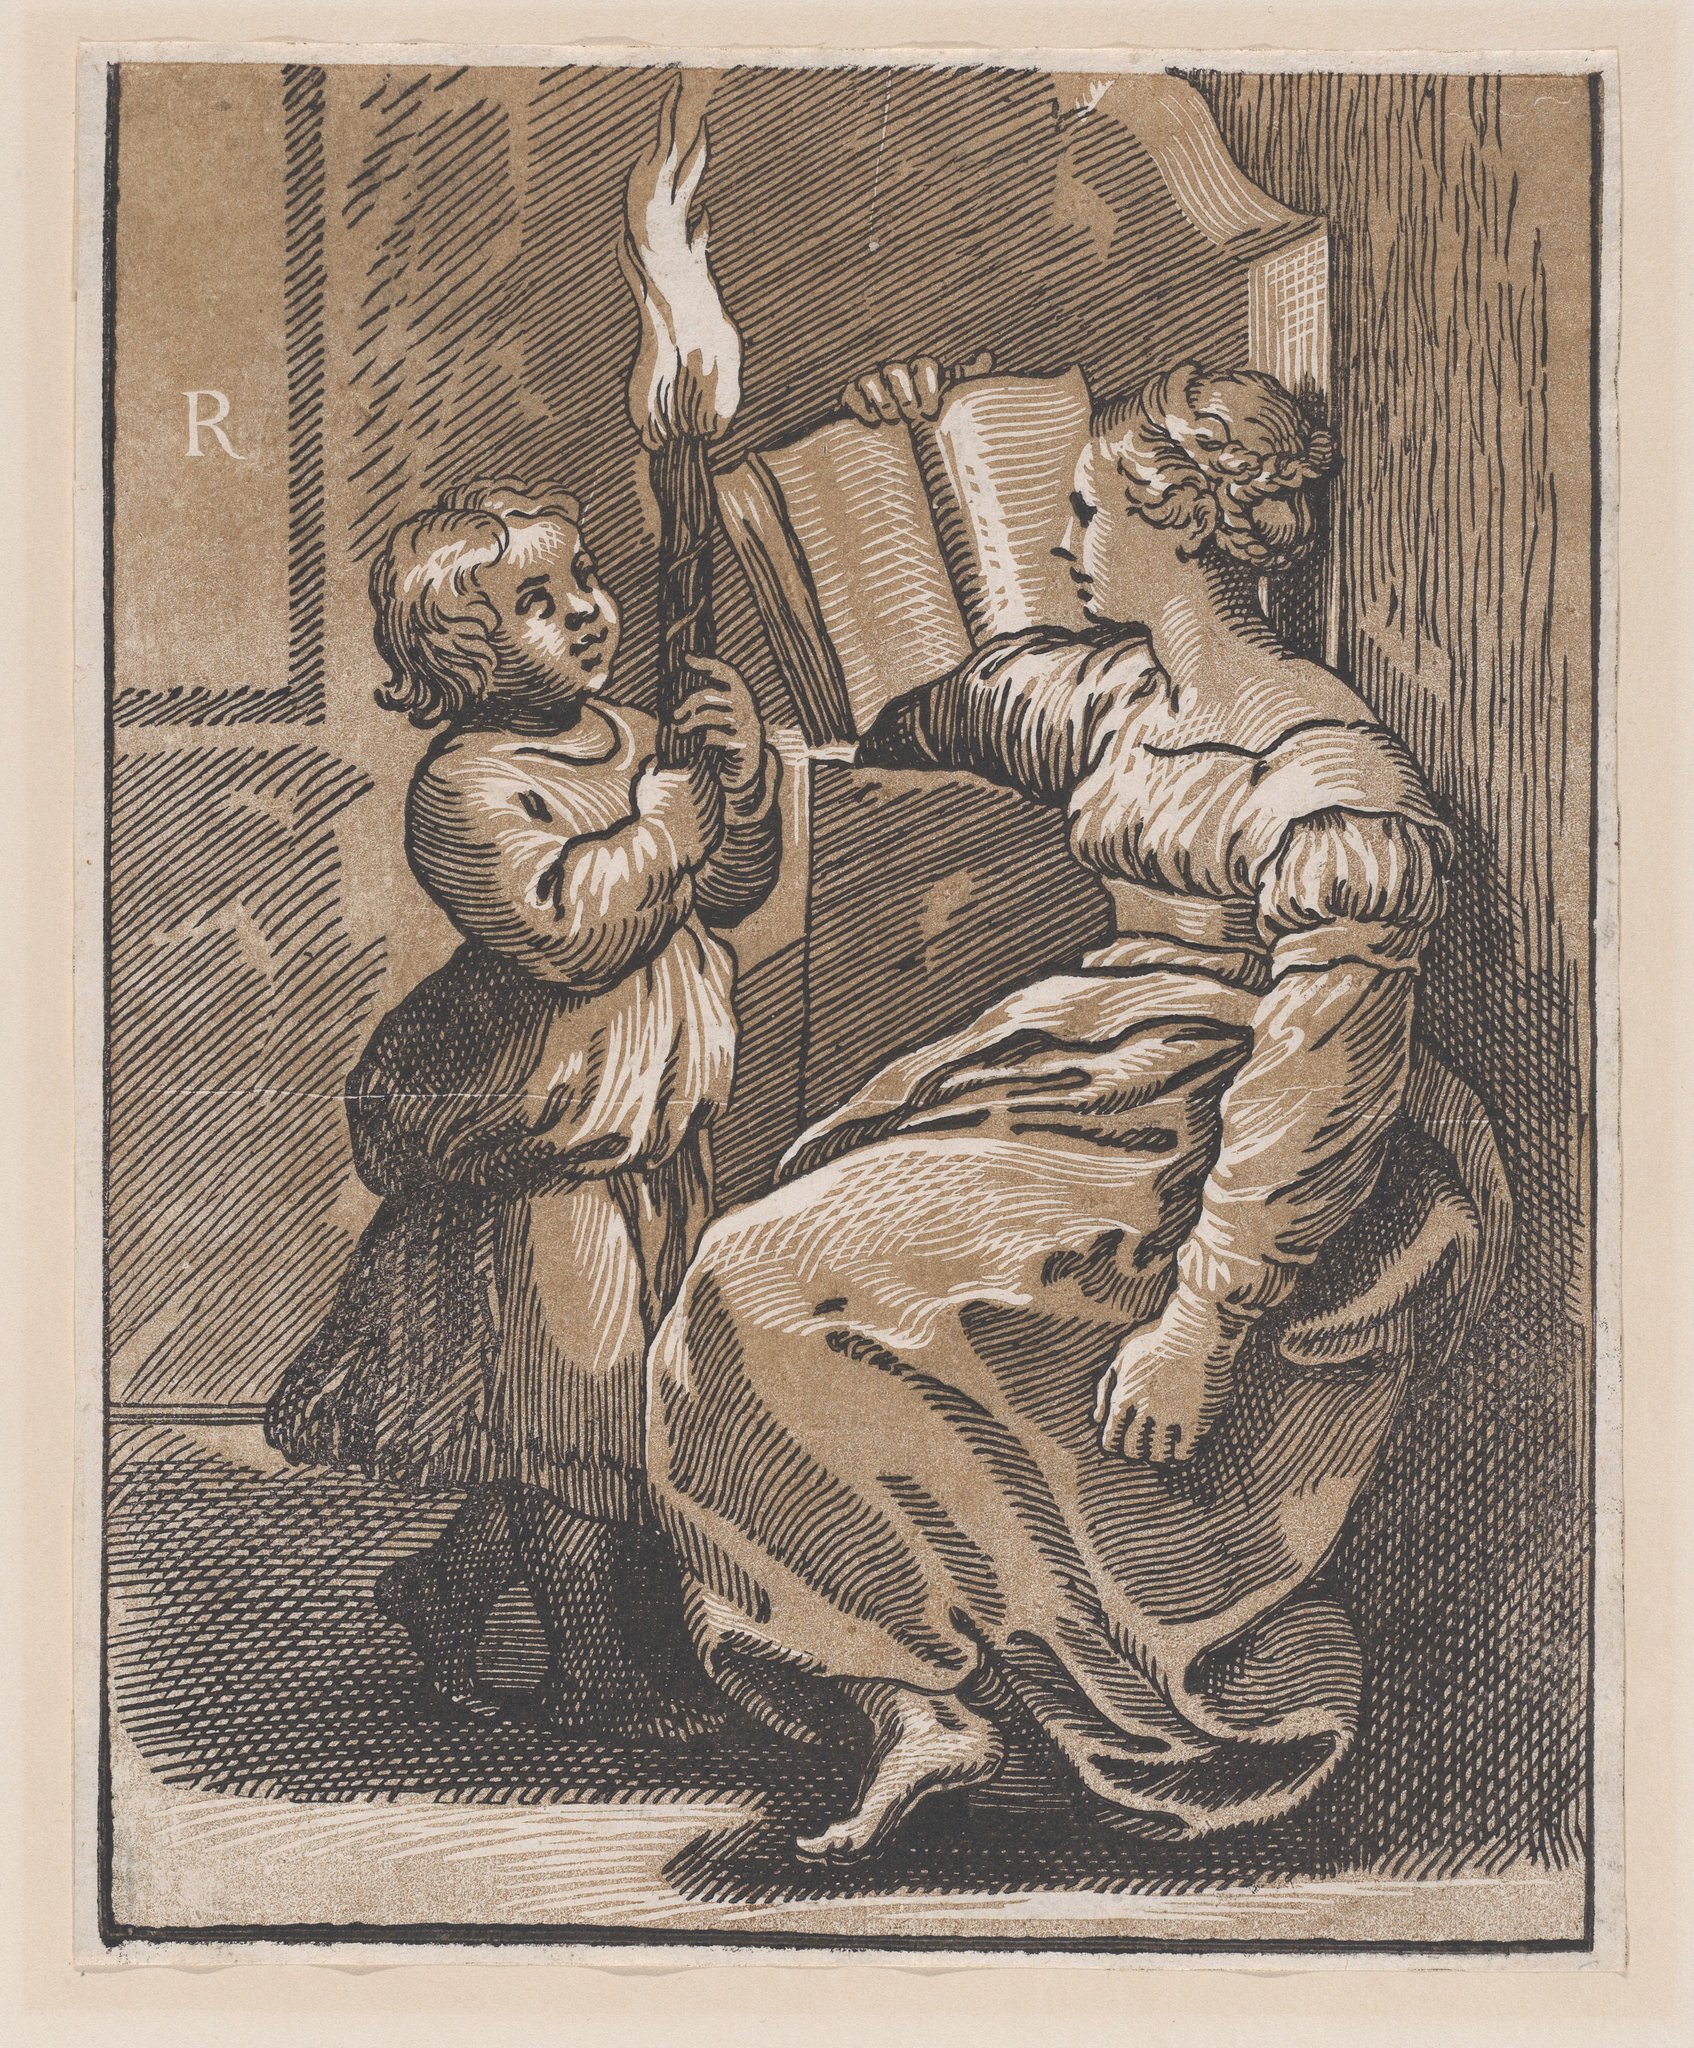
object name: print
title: A Sibyl reading a book facing left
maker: ugo da carpi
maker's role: artist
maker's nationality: italian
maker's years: 1480-1532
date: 1518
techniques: woodcut